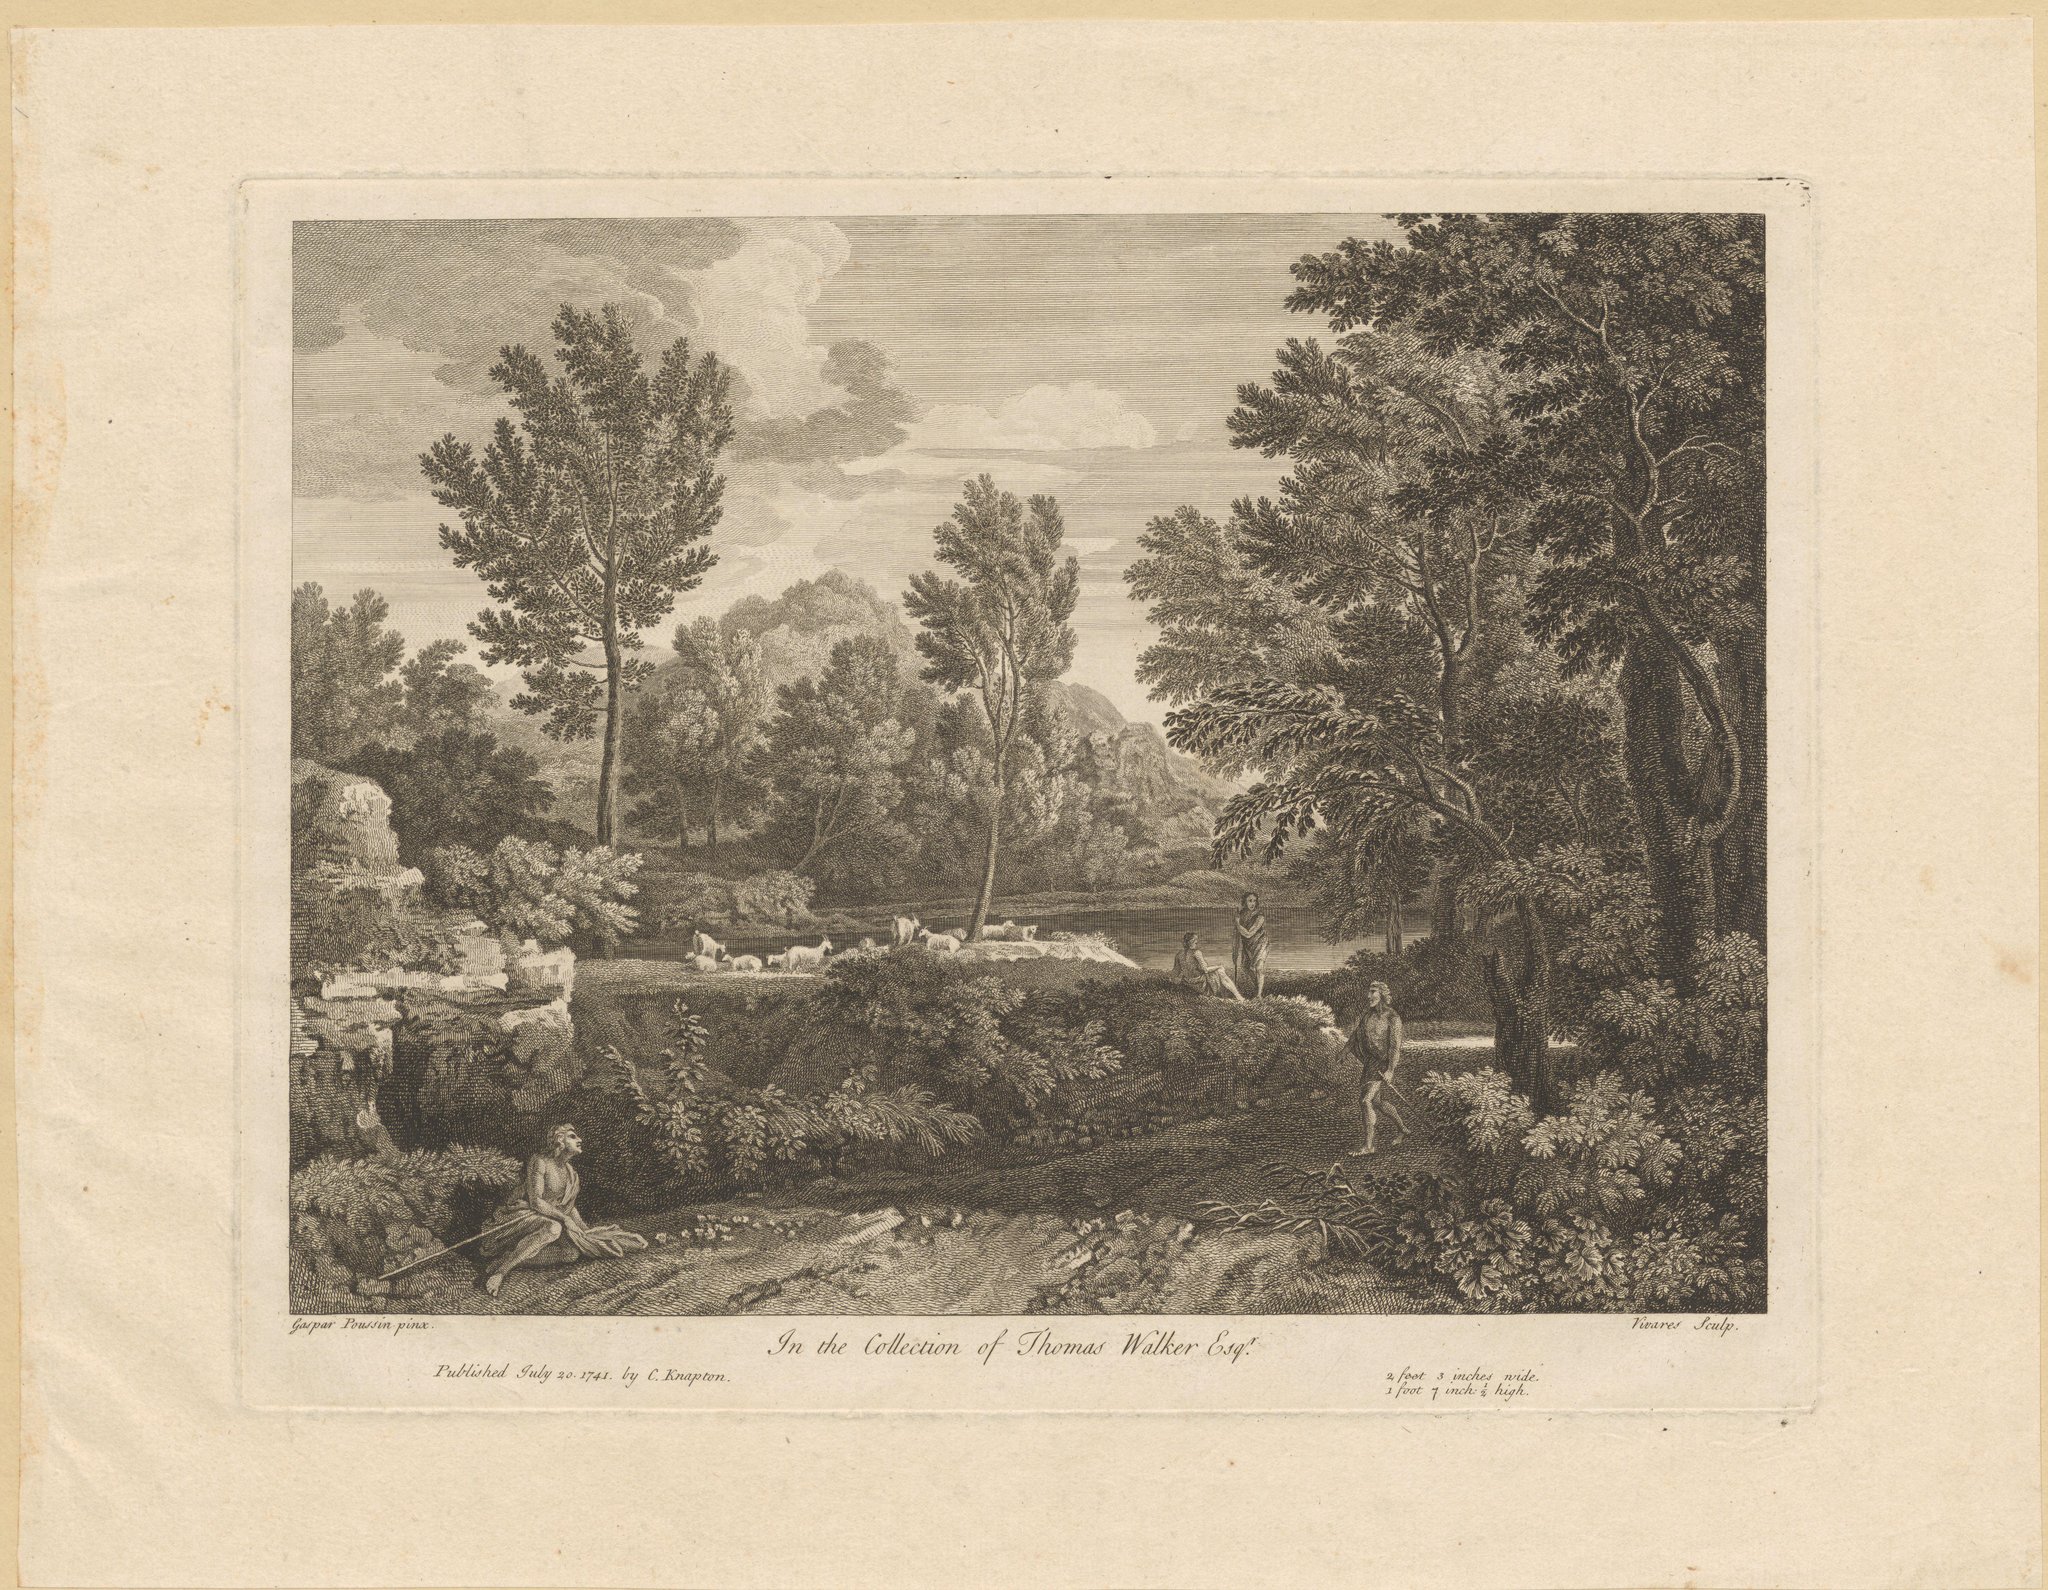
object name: print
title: Boslandschap met herders bij een meer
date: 1741-1780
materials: paper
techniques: etching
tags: herding, herdsman, herdswoman, shepherd, shepherdess, cowherd, etc., forest path or lane, forest, wood (+ landscape with figures, staffage)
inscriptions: collector's mark: Lugt 2228